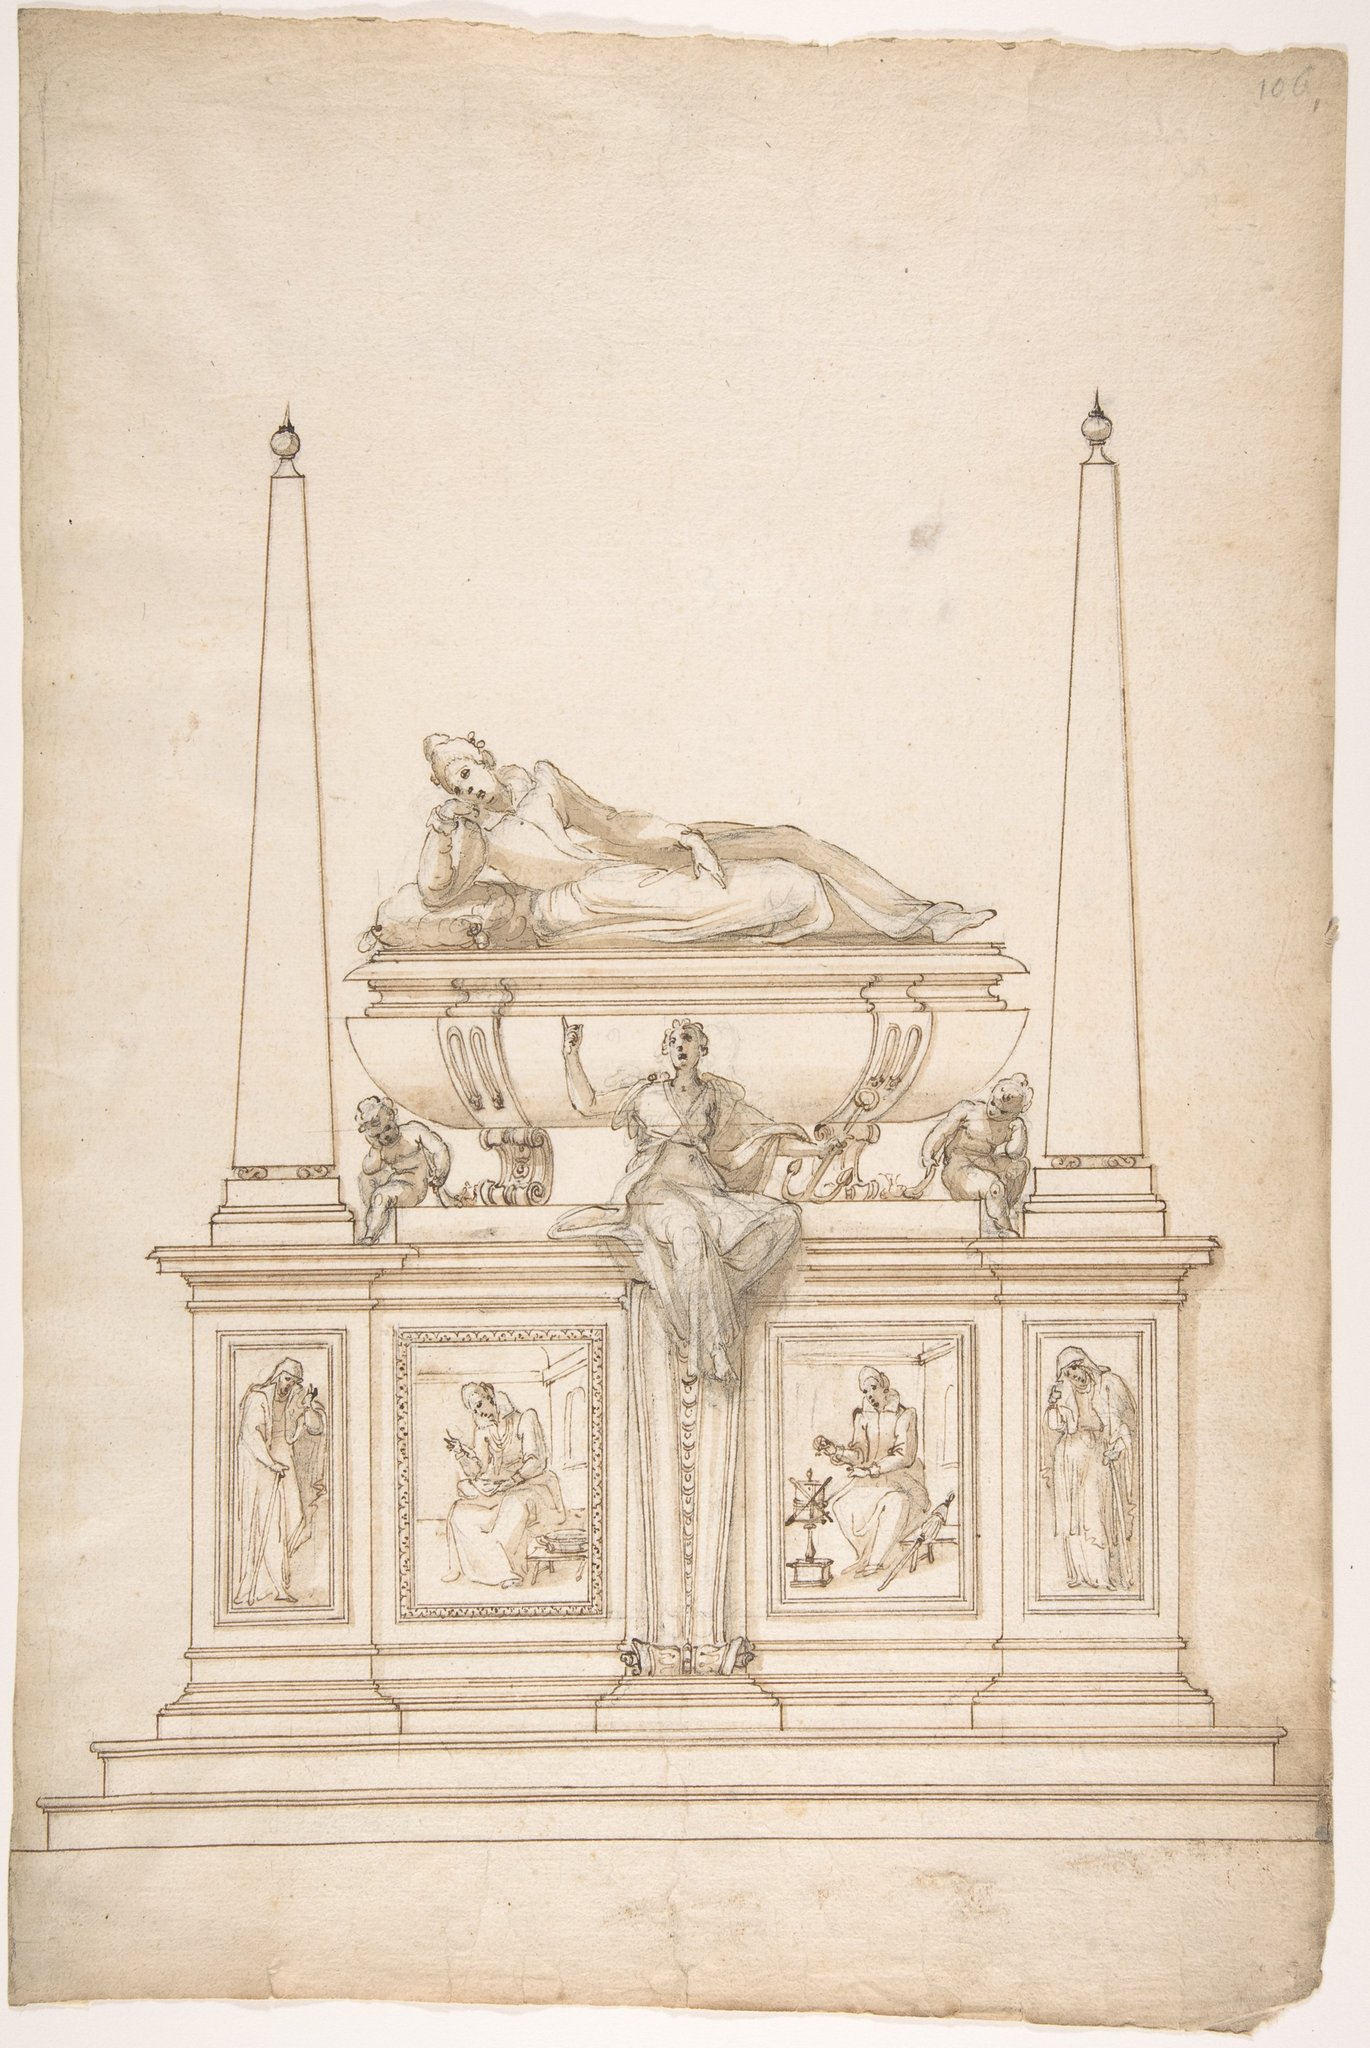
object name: drawing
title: Design for a Lady's Tomb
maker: anonymous, french, 16th century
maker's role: artist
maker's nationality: french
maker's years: 1500-1600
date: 1501-1600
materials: chalk, ink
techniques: brush, pen, wash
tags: human figures,tombs